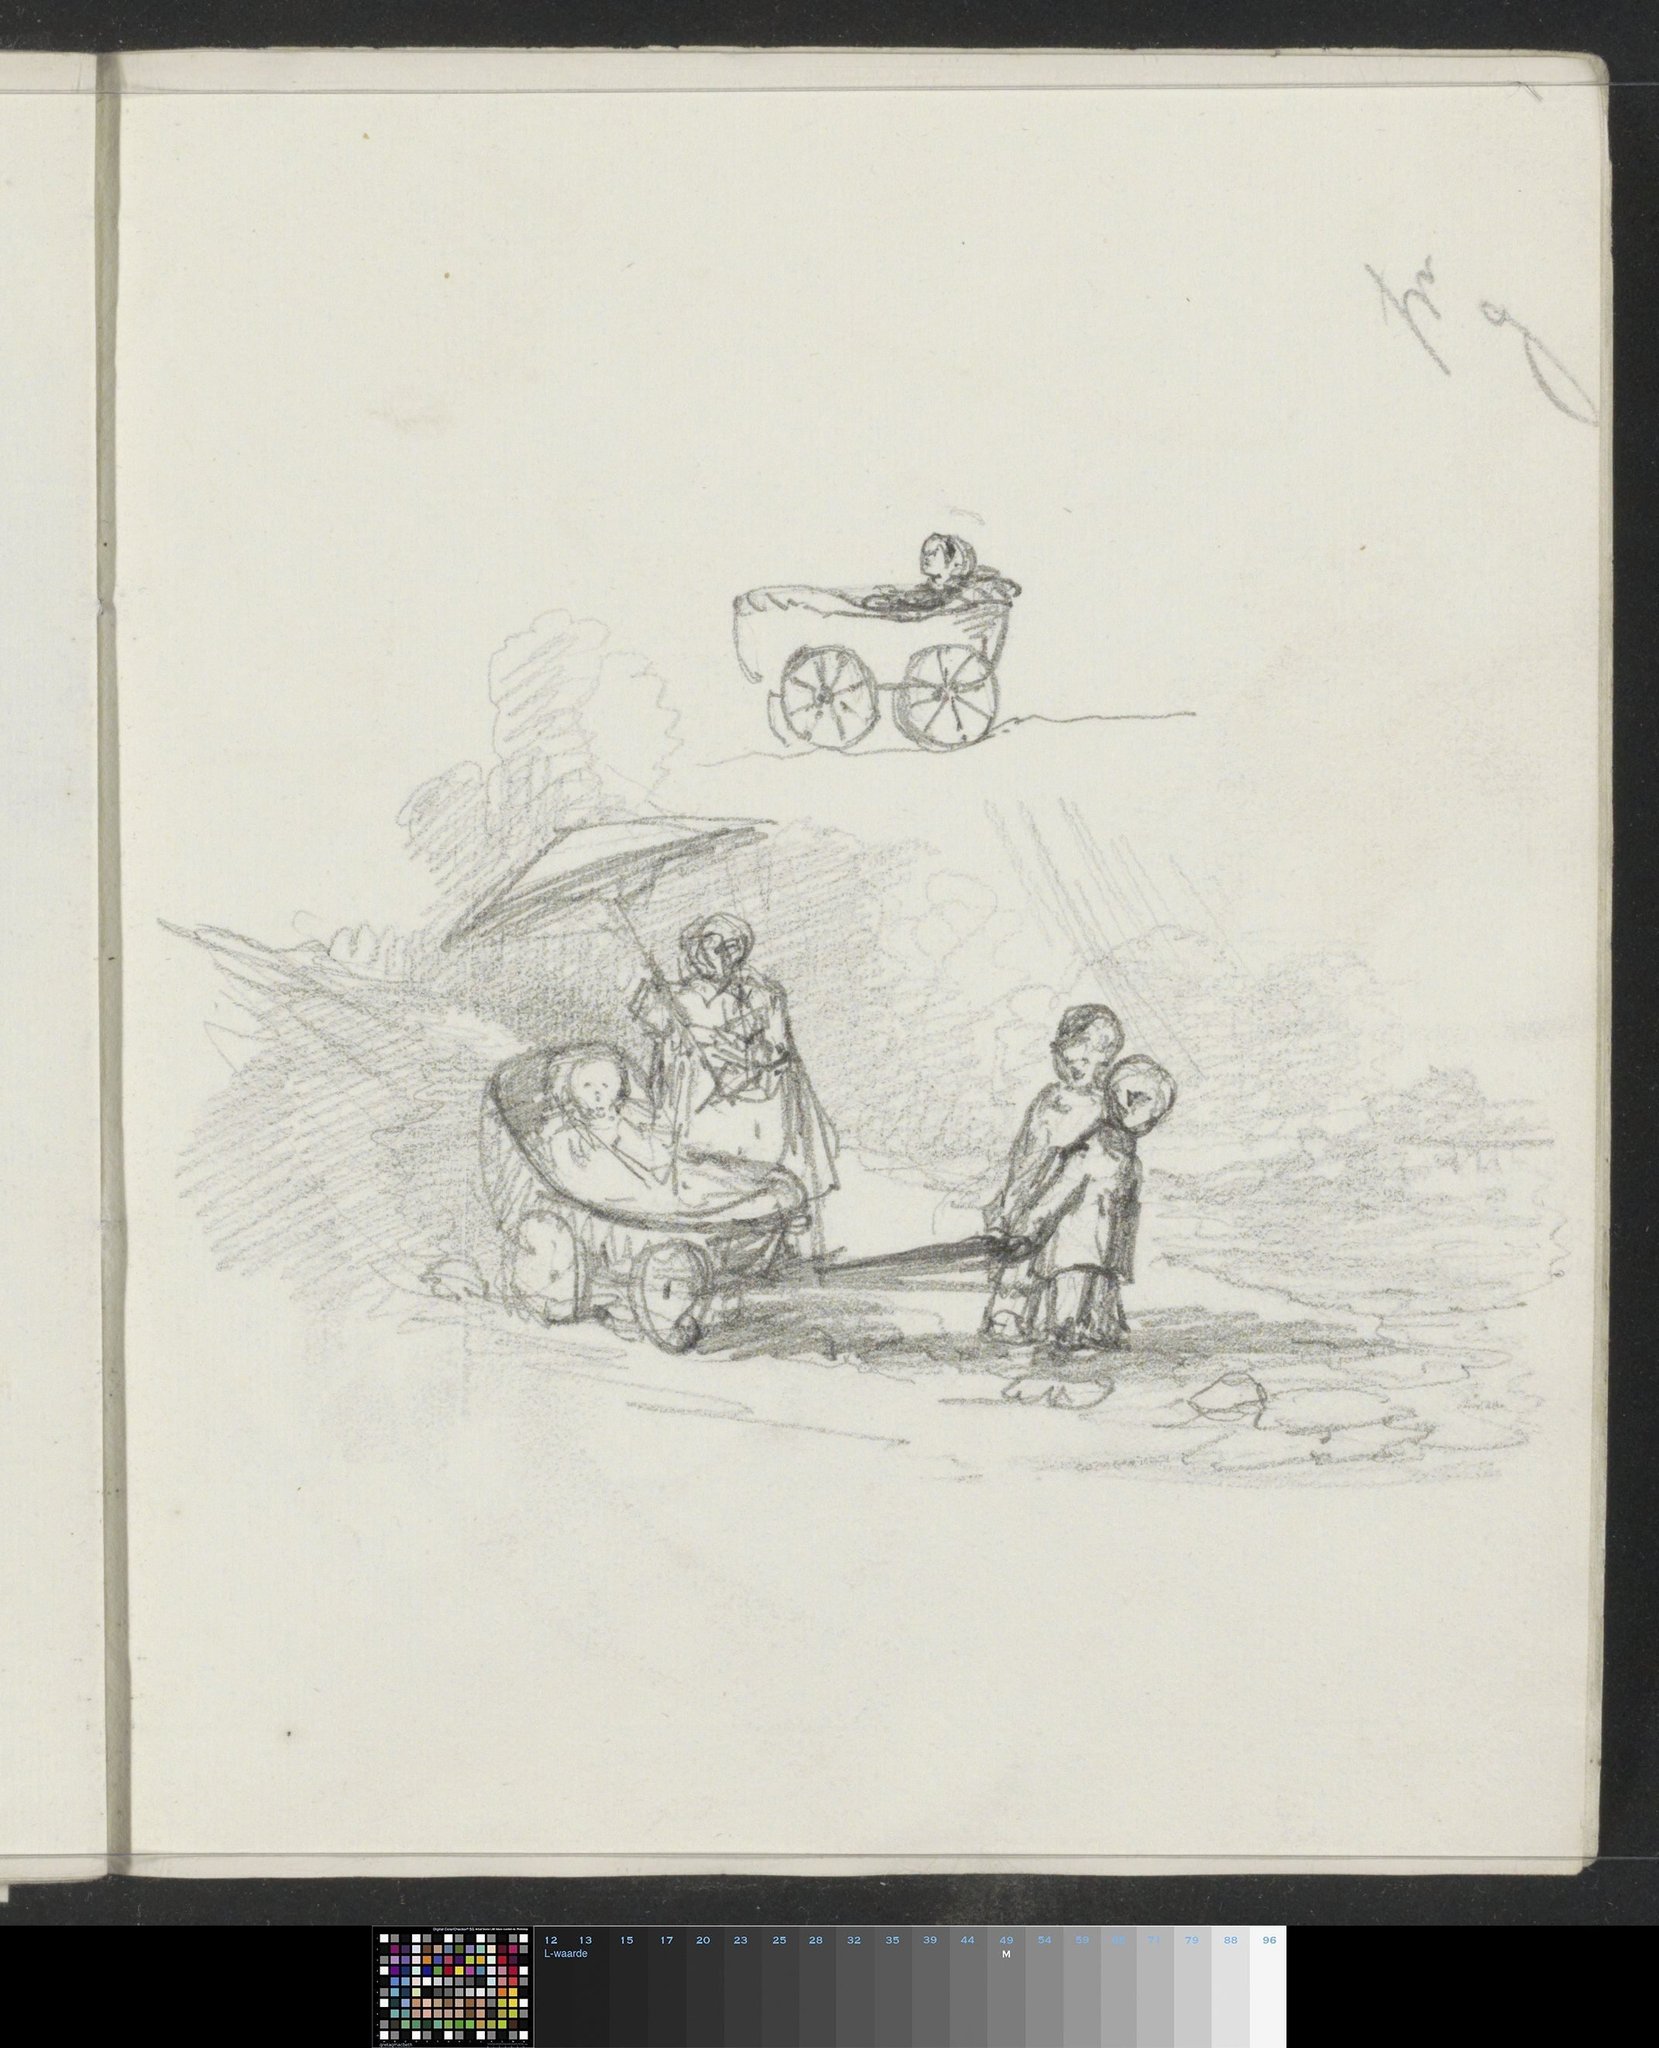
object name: sketchbook leaf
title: Vrouw met een parasol en twee kinderen bij een baby in een kinderwagen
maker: maria vos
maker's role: draughtsman, painter, print maker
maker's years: 1824-1906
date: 1834-1906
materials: paper, pencil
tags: baby-carriage, pram, perambulator, child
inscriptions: annotation: ‘[...]r/ g’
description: Tevens een studie van een baby in een kinderwagen. Blad 17 recto uit een schetsboek met 20 bladen.